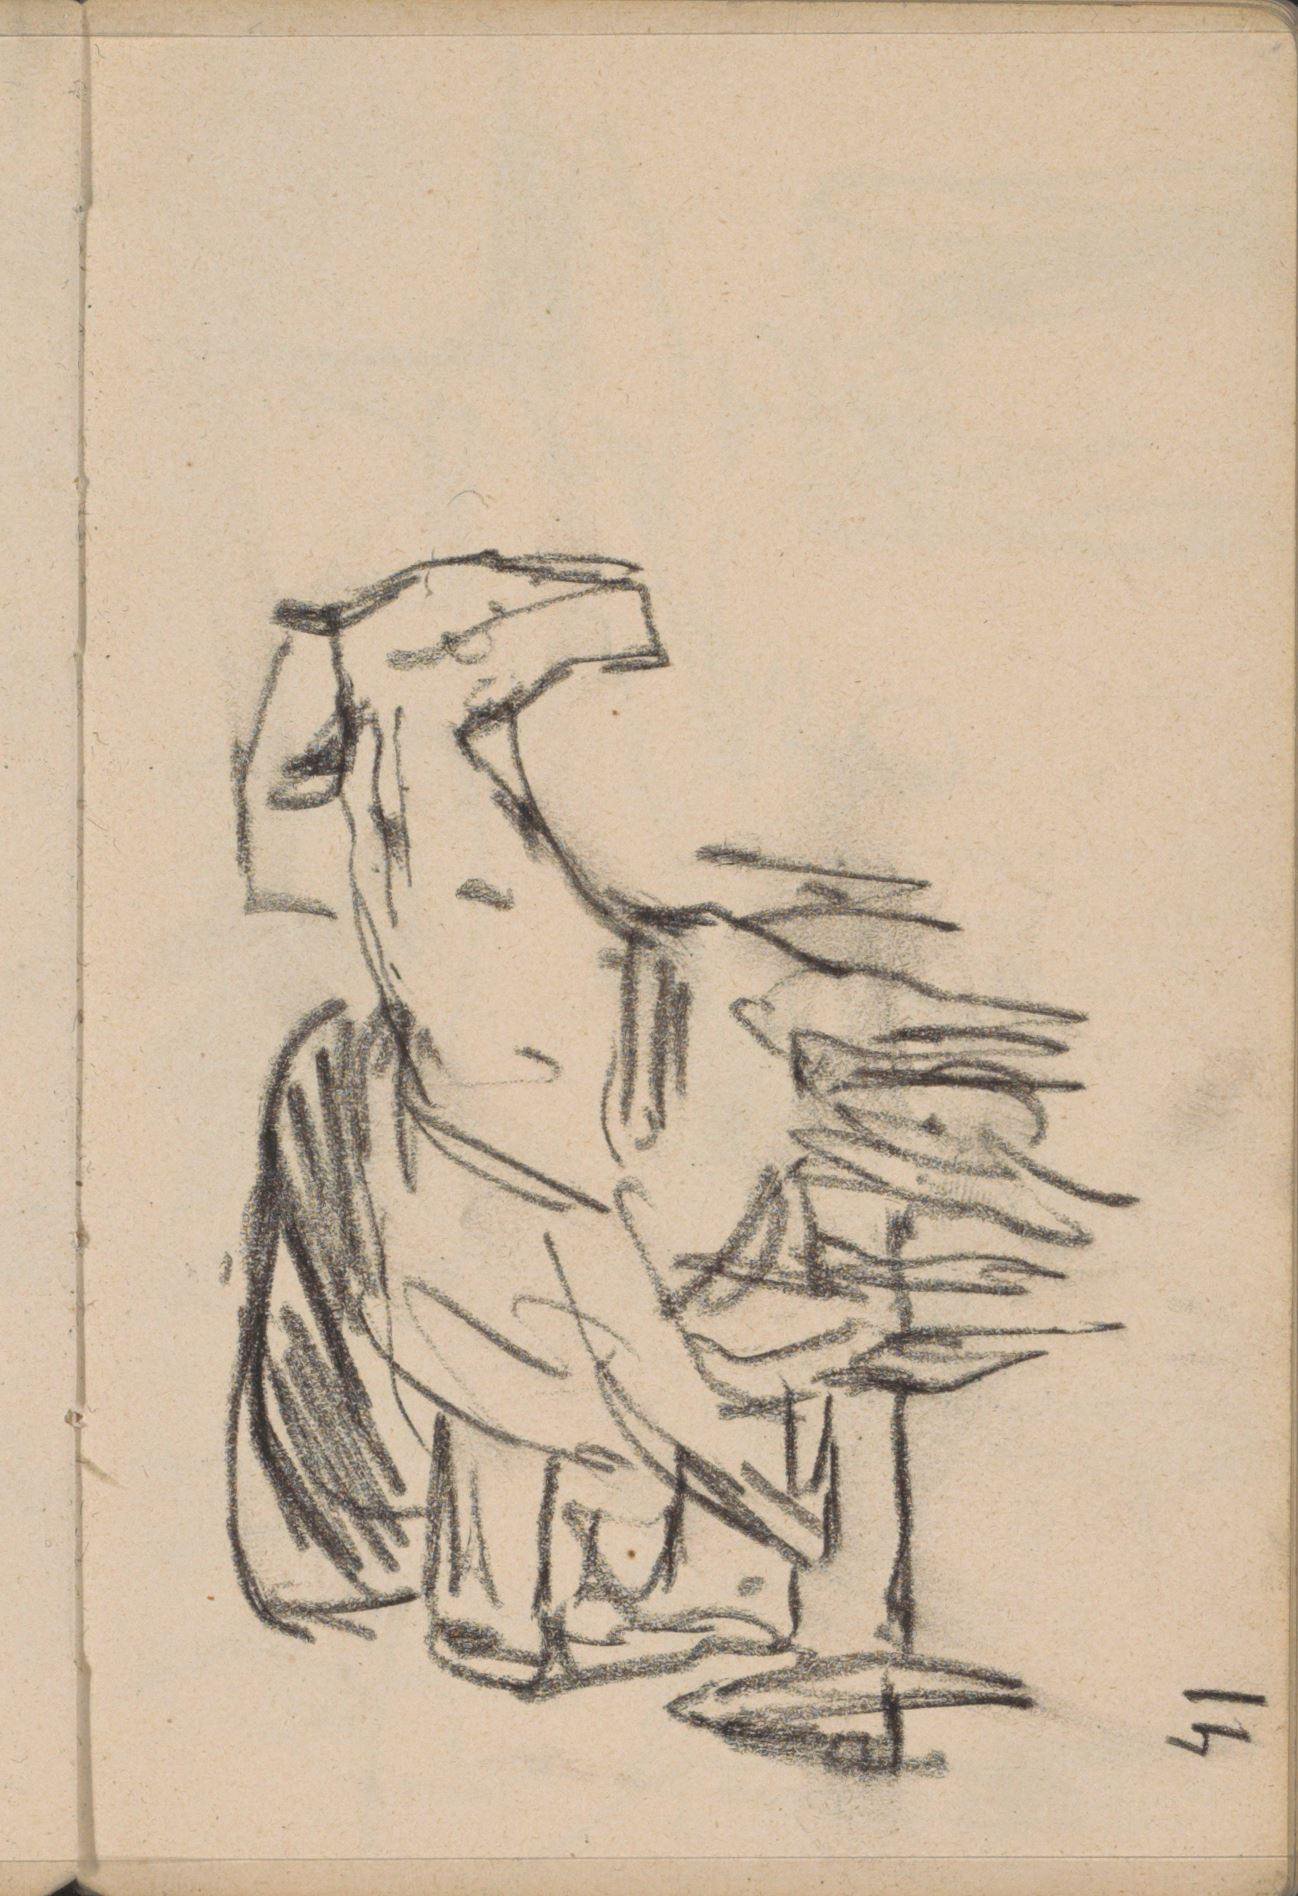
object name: sketchbook leaf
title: Paard-en-wagen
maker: george hendrik breitner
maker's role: draughtsman, painter, print maker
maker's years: 1857-1923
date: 1914-1923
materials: chalk, paper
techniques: stumping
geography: amsterdam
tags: four-wheeled vehicle drawn by one animal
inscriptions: number: ‘41’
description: Paard-en-wagen. Pagina 14 uit een schetsboek met 43 bladen vervaardigd te Amsterdam.